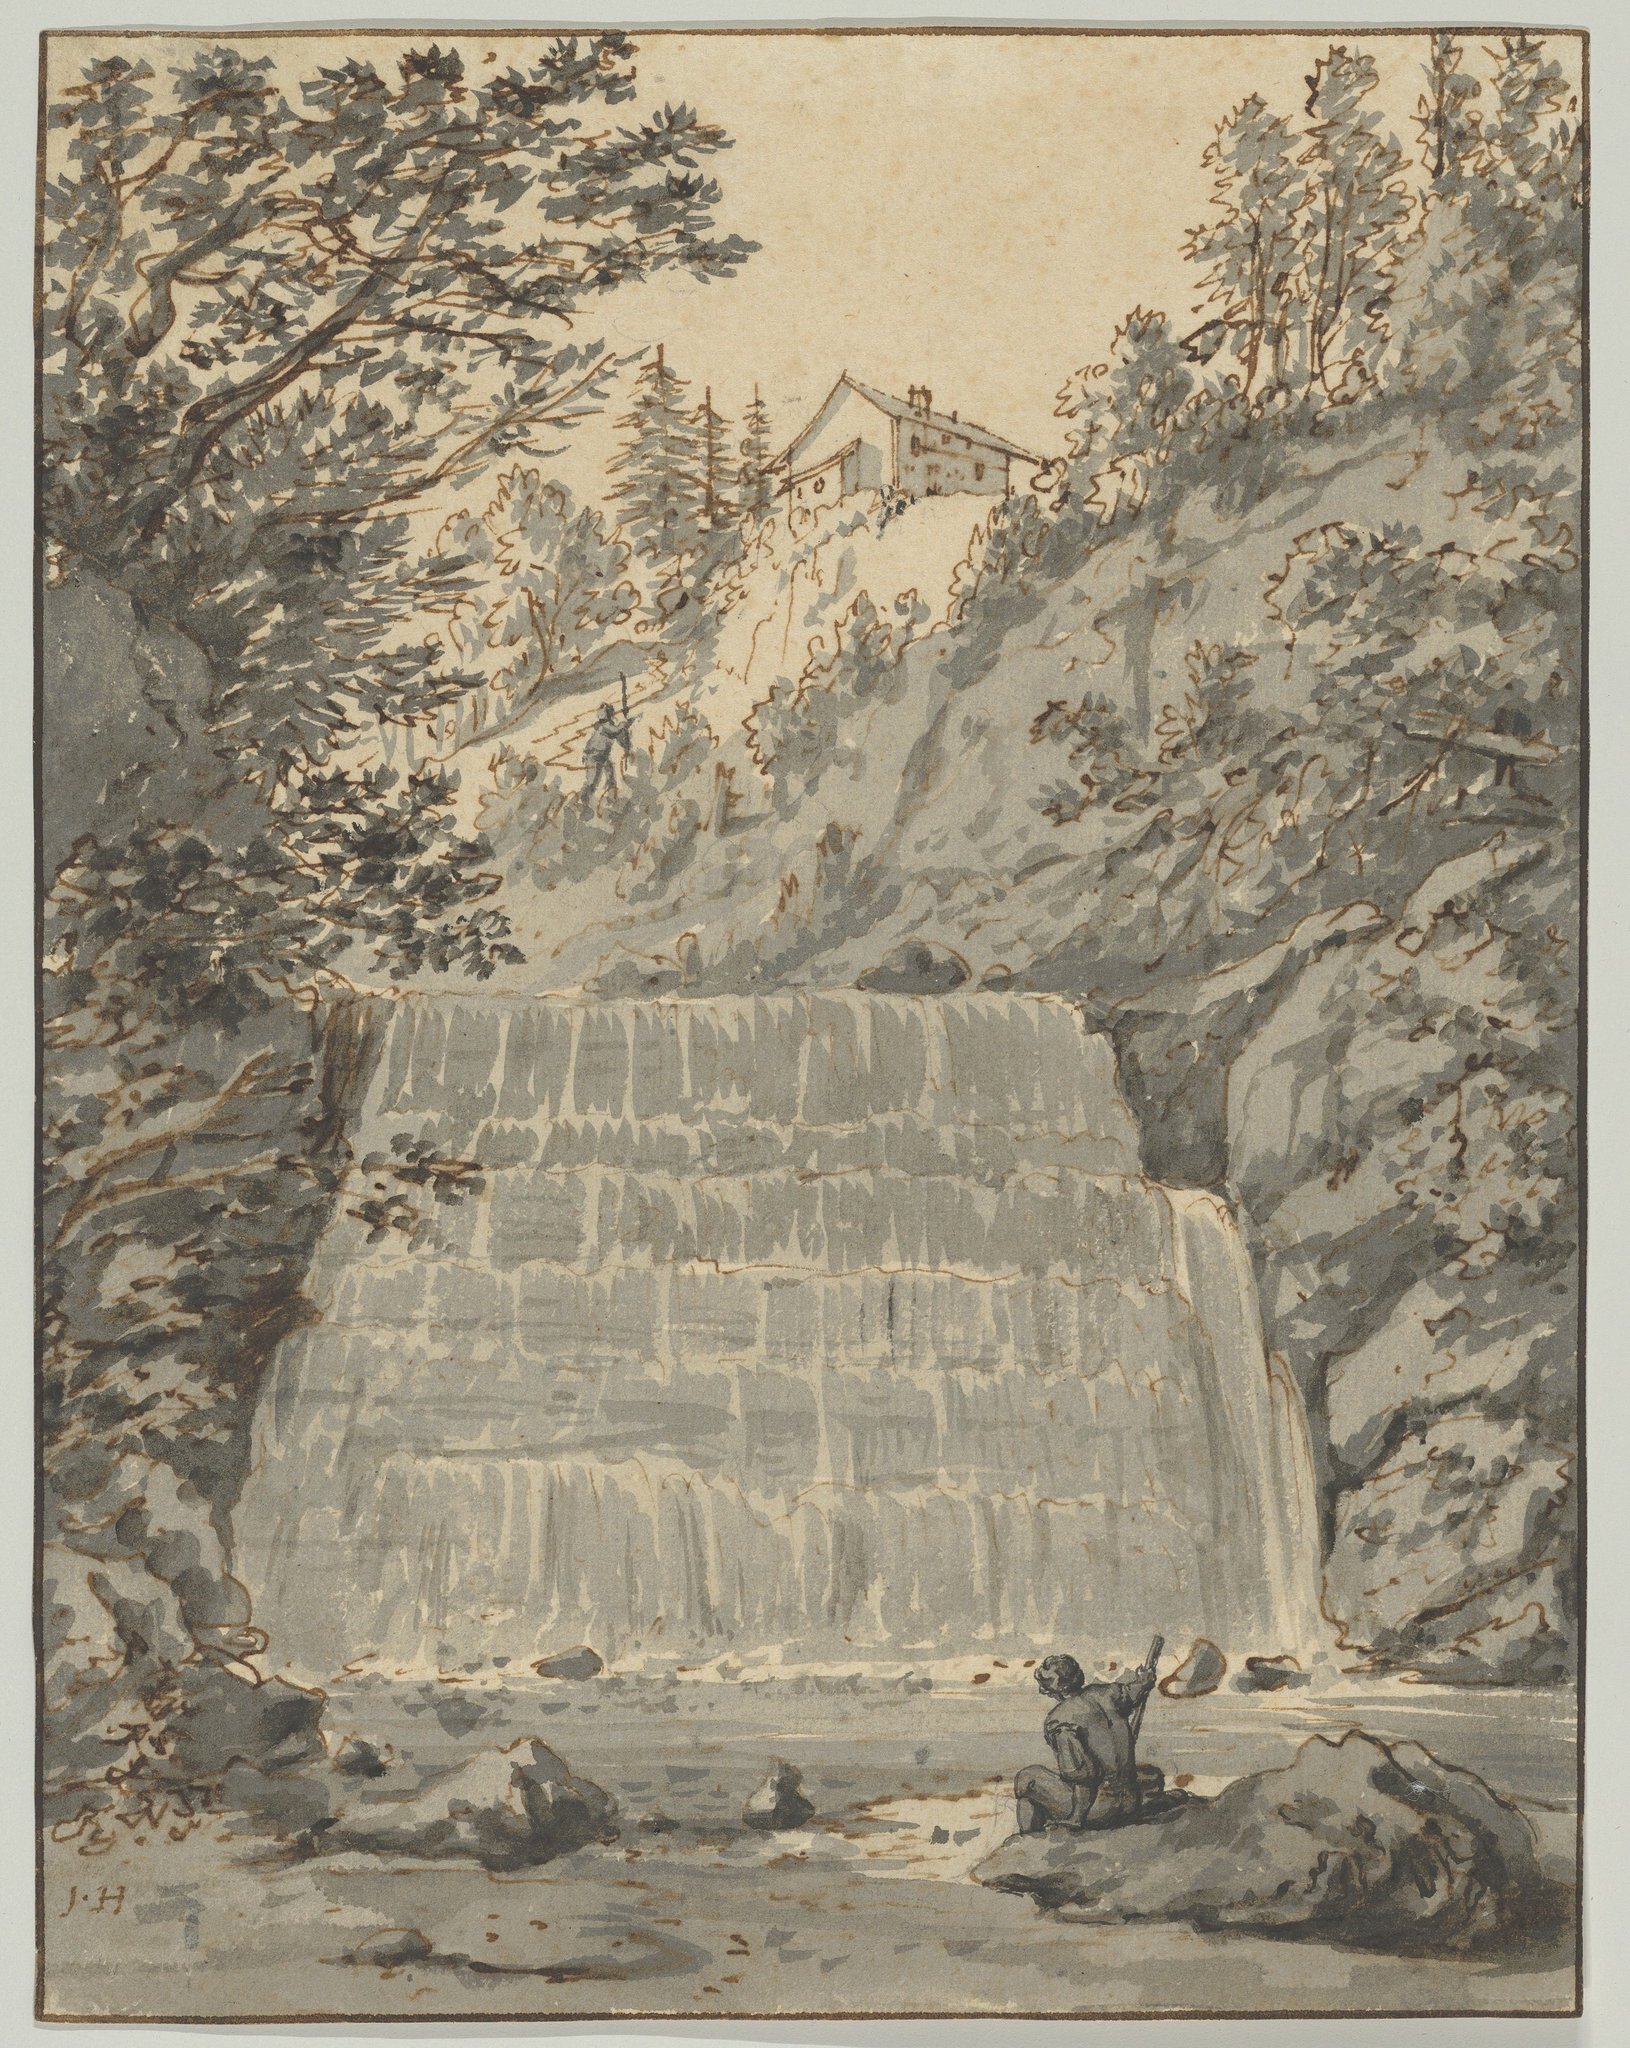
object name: drawing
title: A Waterfall in Switzerland (near Lausanne?) with a Resting Wayfarer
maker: jan hackaert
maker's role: artist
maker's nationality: dutch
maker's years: 1628-1685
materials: ink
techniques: brush, pen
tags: human figures,waterfalls